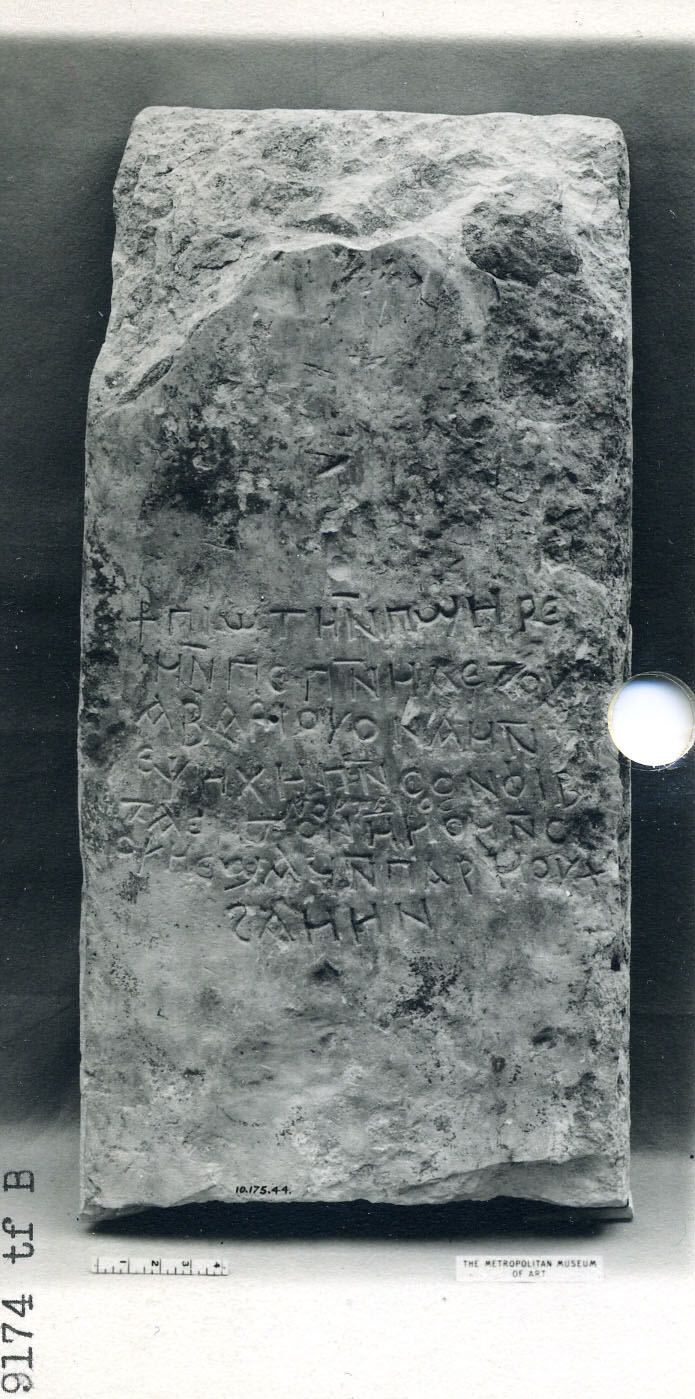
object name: stele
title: Inscribed Stele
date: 501-700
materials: limestone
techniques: incising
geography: egypt